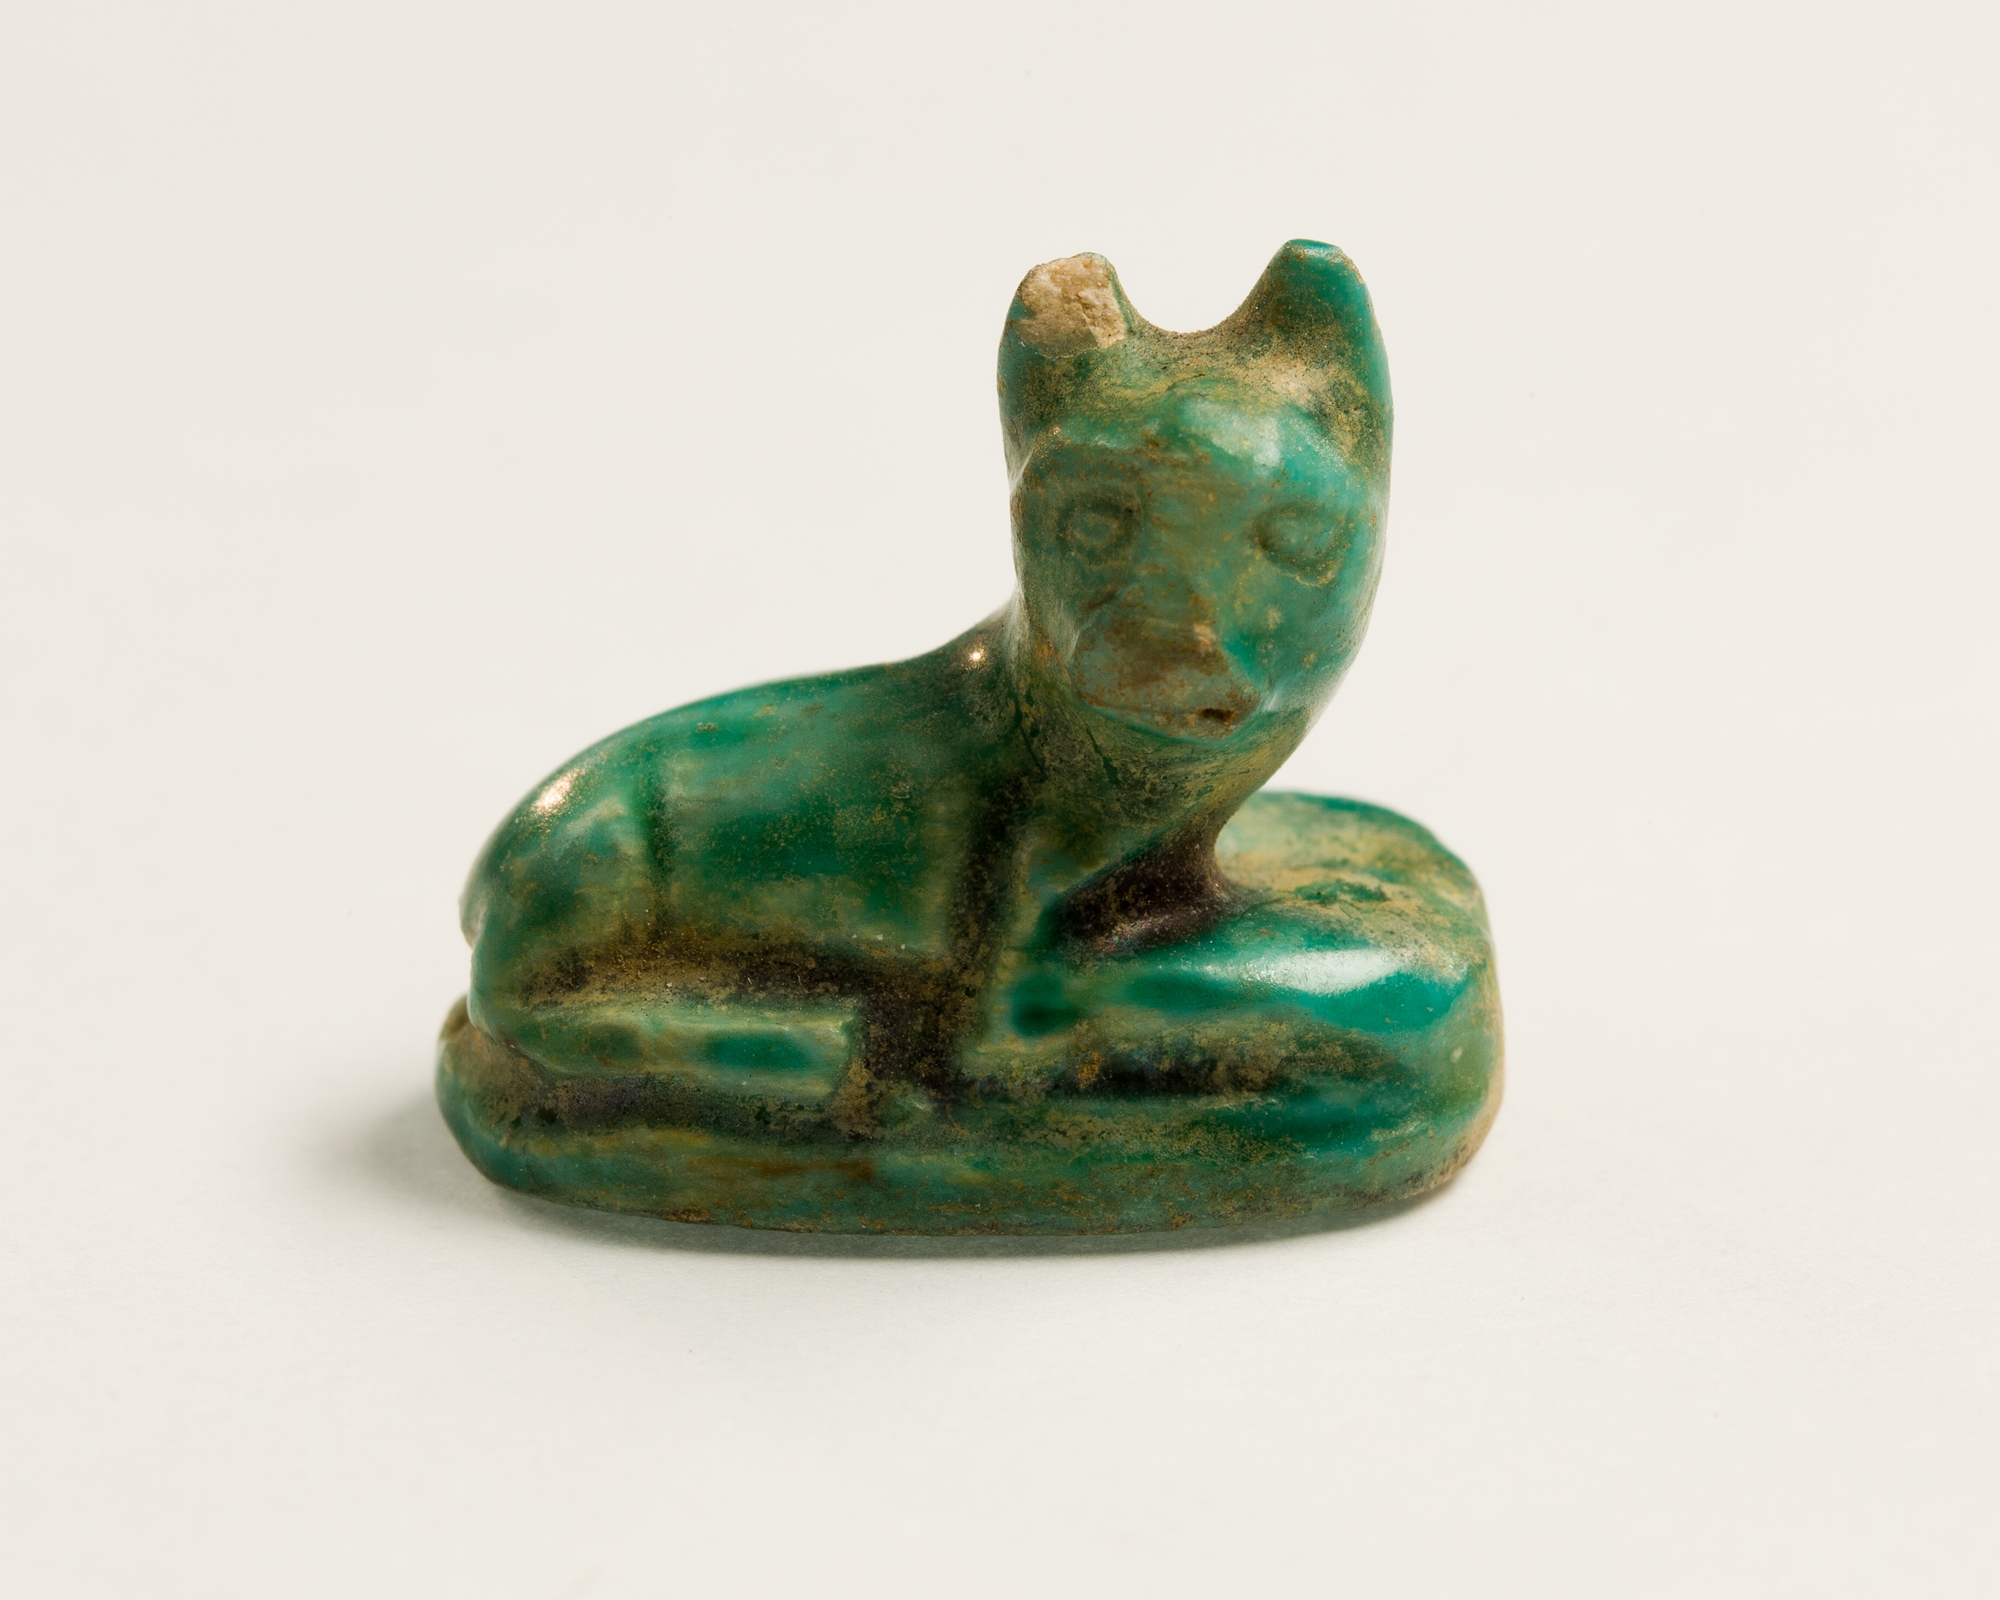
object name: seal amulet, cat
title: Seal with a Figure of a Cat on Top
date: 664-332 BCE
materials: stone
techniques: glazing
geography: egypt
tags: cats